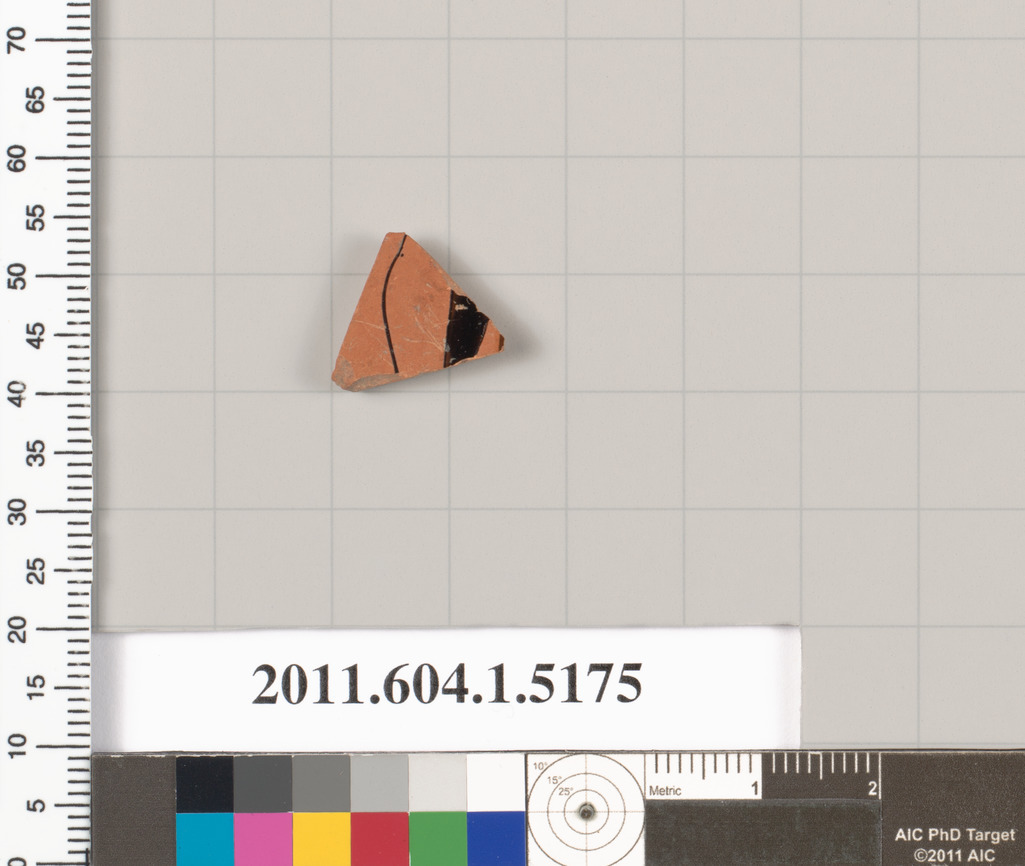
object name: kylix fragment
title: Terracotta fragment of a kylix (drinking cup)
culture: greek, attic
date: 500-480 BCE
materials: terracotta